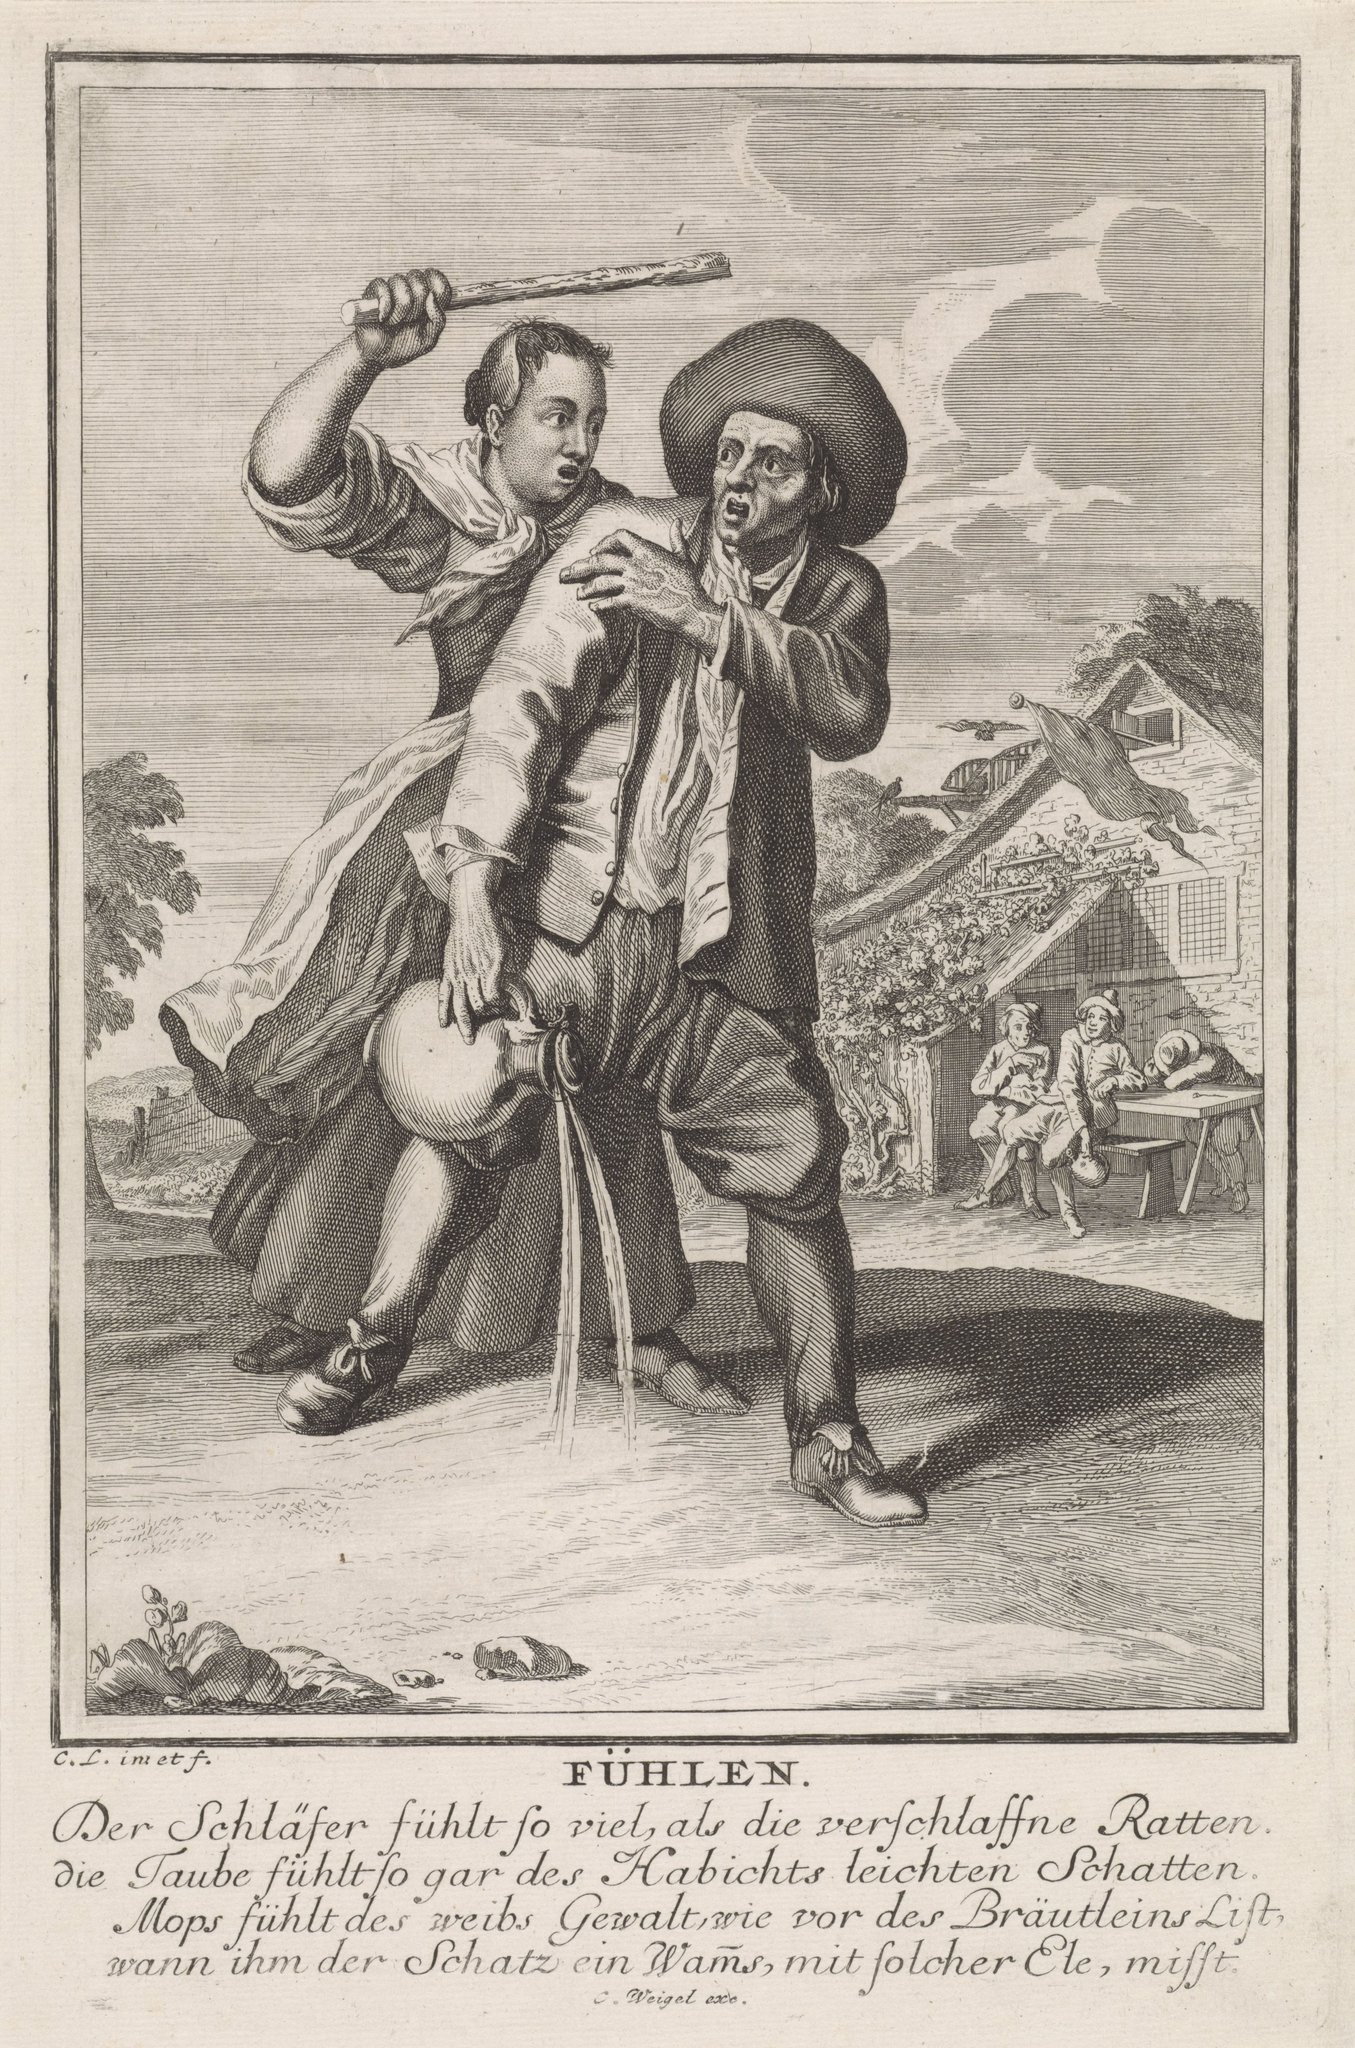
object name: print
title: Fühlen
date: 1698-1702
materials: paper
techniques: engraving, etching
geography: nuremberg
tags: hitting at something - aa - female human figure, inn, coffee-house, public house, etc., feeling (one of the five senses)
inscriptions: collector's mark: Lugt 2228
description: Een man met een wijnkan in de hand wordt door een vrouw geslagen met een stuk hout. Op de achtergrond een herberg met enkele andere dronken boeren. De prent heeft een Duits onderschrift van vier regels over het zintuig tastzin.